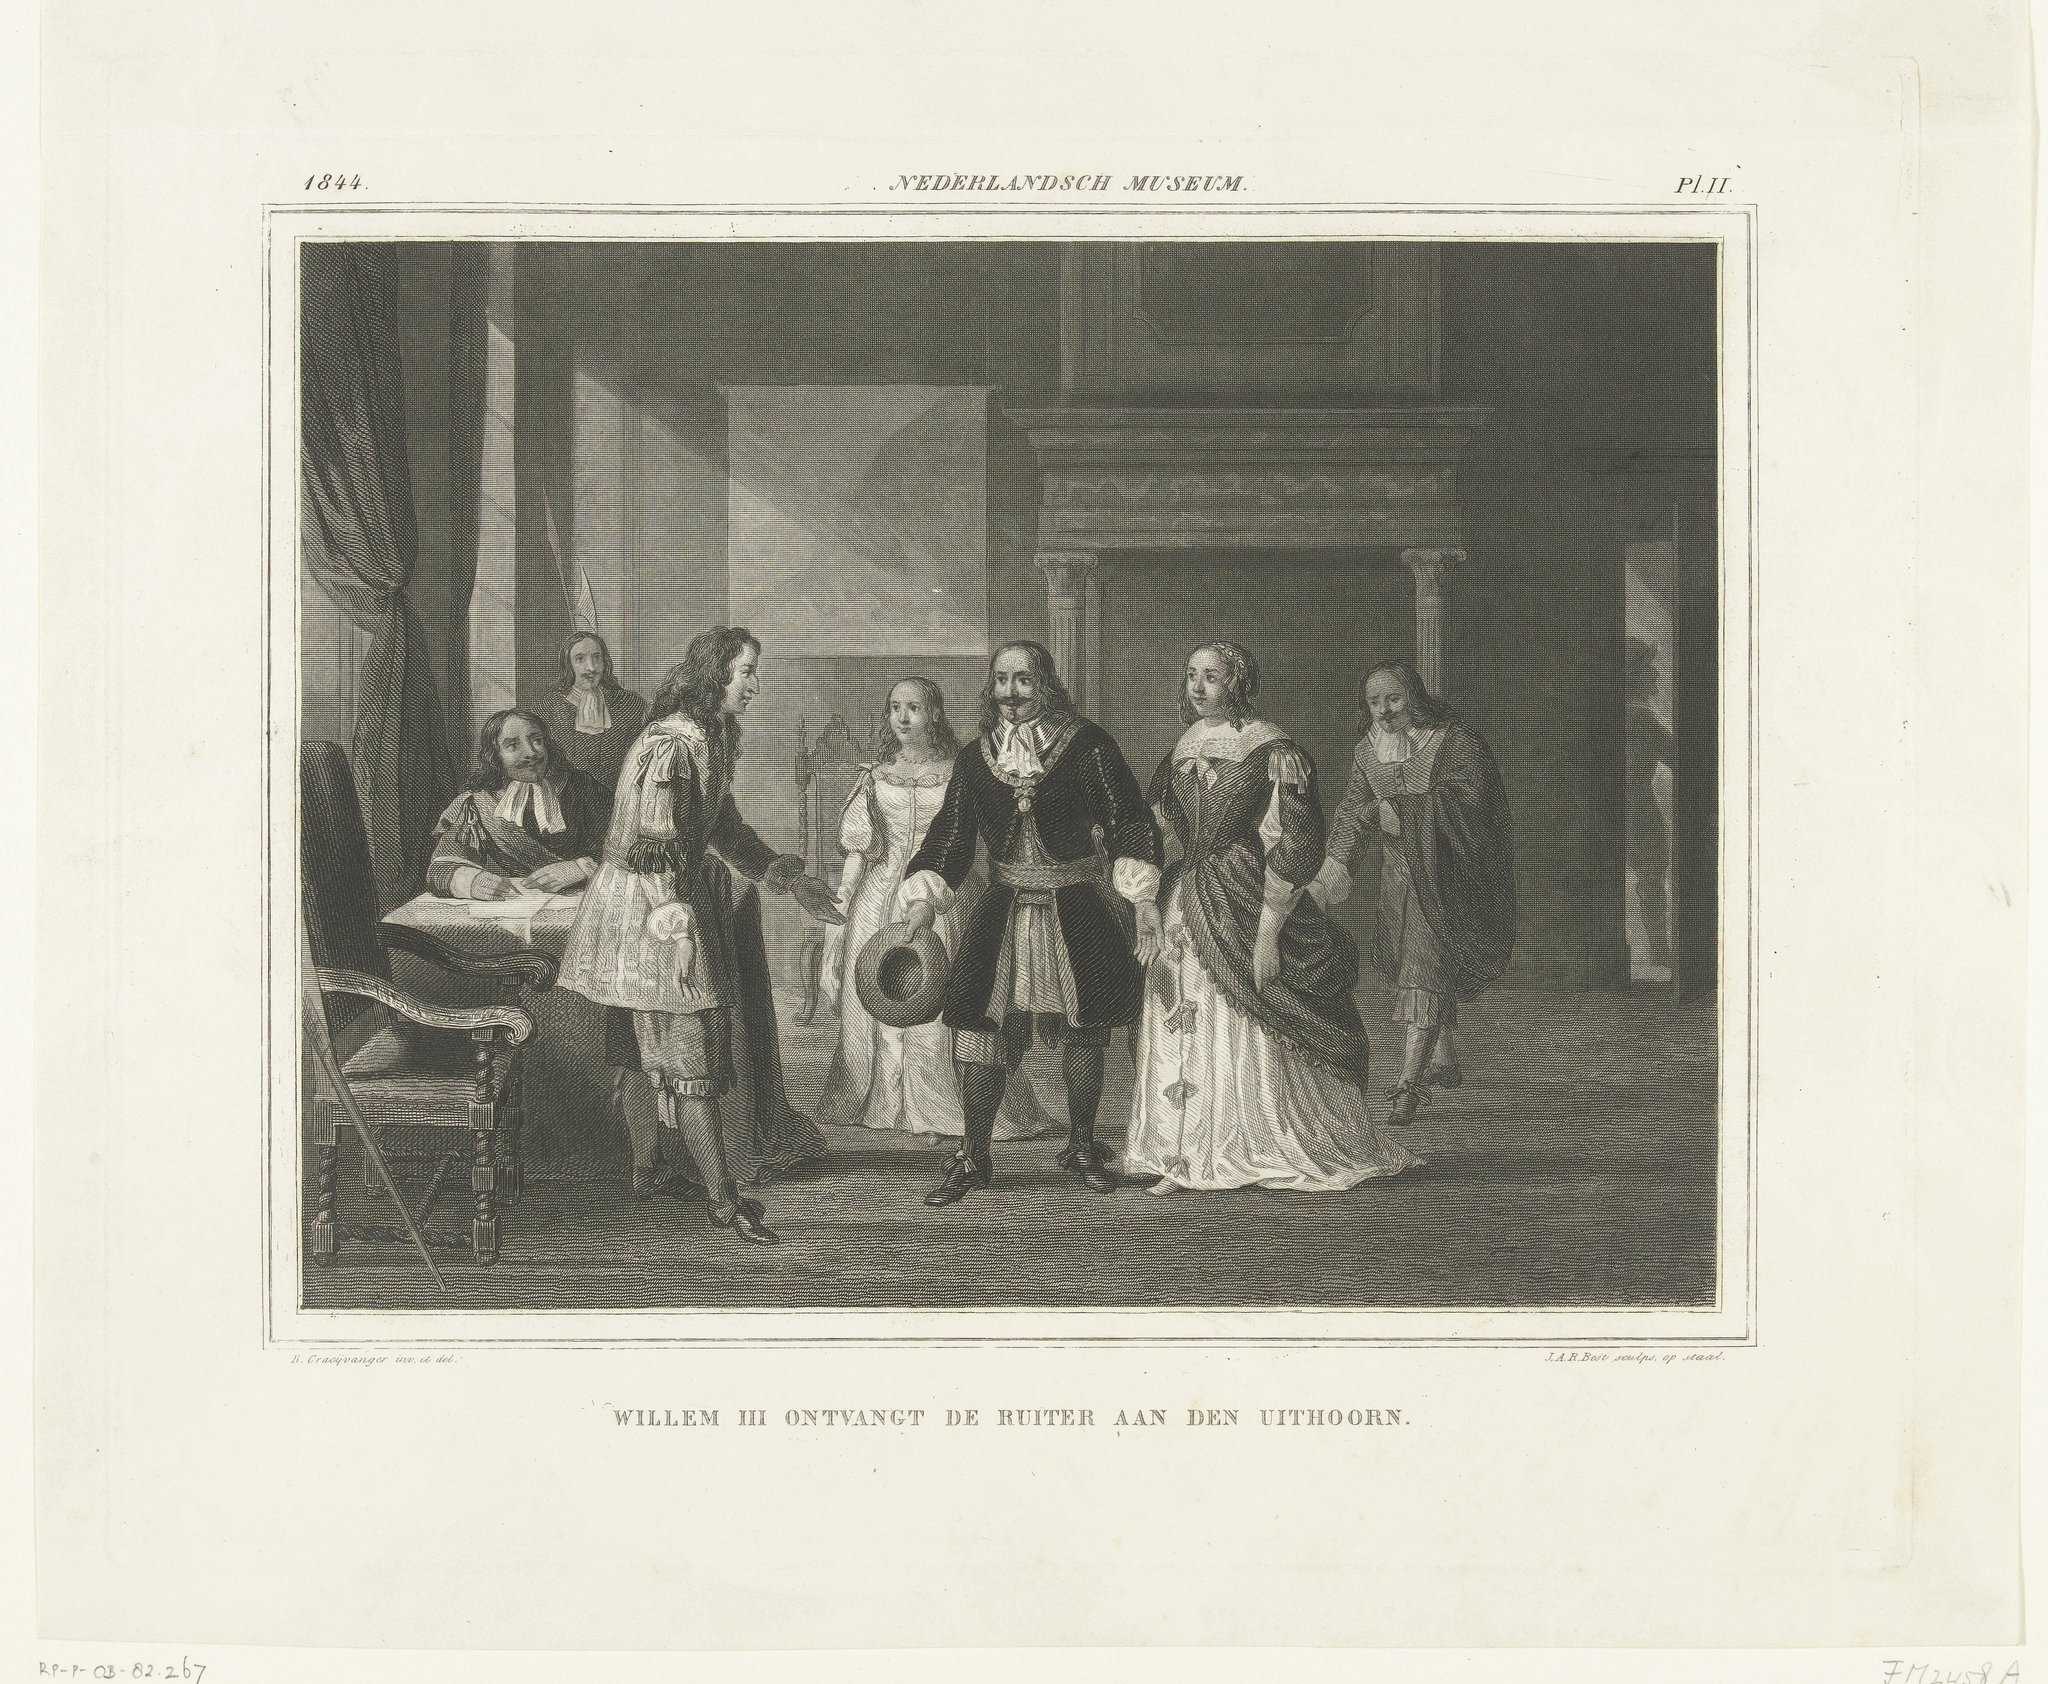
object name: history print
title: Willem III ontvangt De Ruiter aan Den Uithoorn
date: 1844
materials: paper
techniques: engraving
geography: netherlands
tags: flushing, michiel adriaenszoon de ruyter, william iii (prince of orange and king of england, scotland, and ireland), audition; ruler giving audience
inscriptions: date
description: In een interieur ontvangt prins Willem III admiraal Michiel Adriaenszoon de Ruyter en zijn vrouw en dochter, februari (?) 1673.